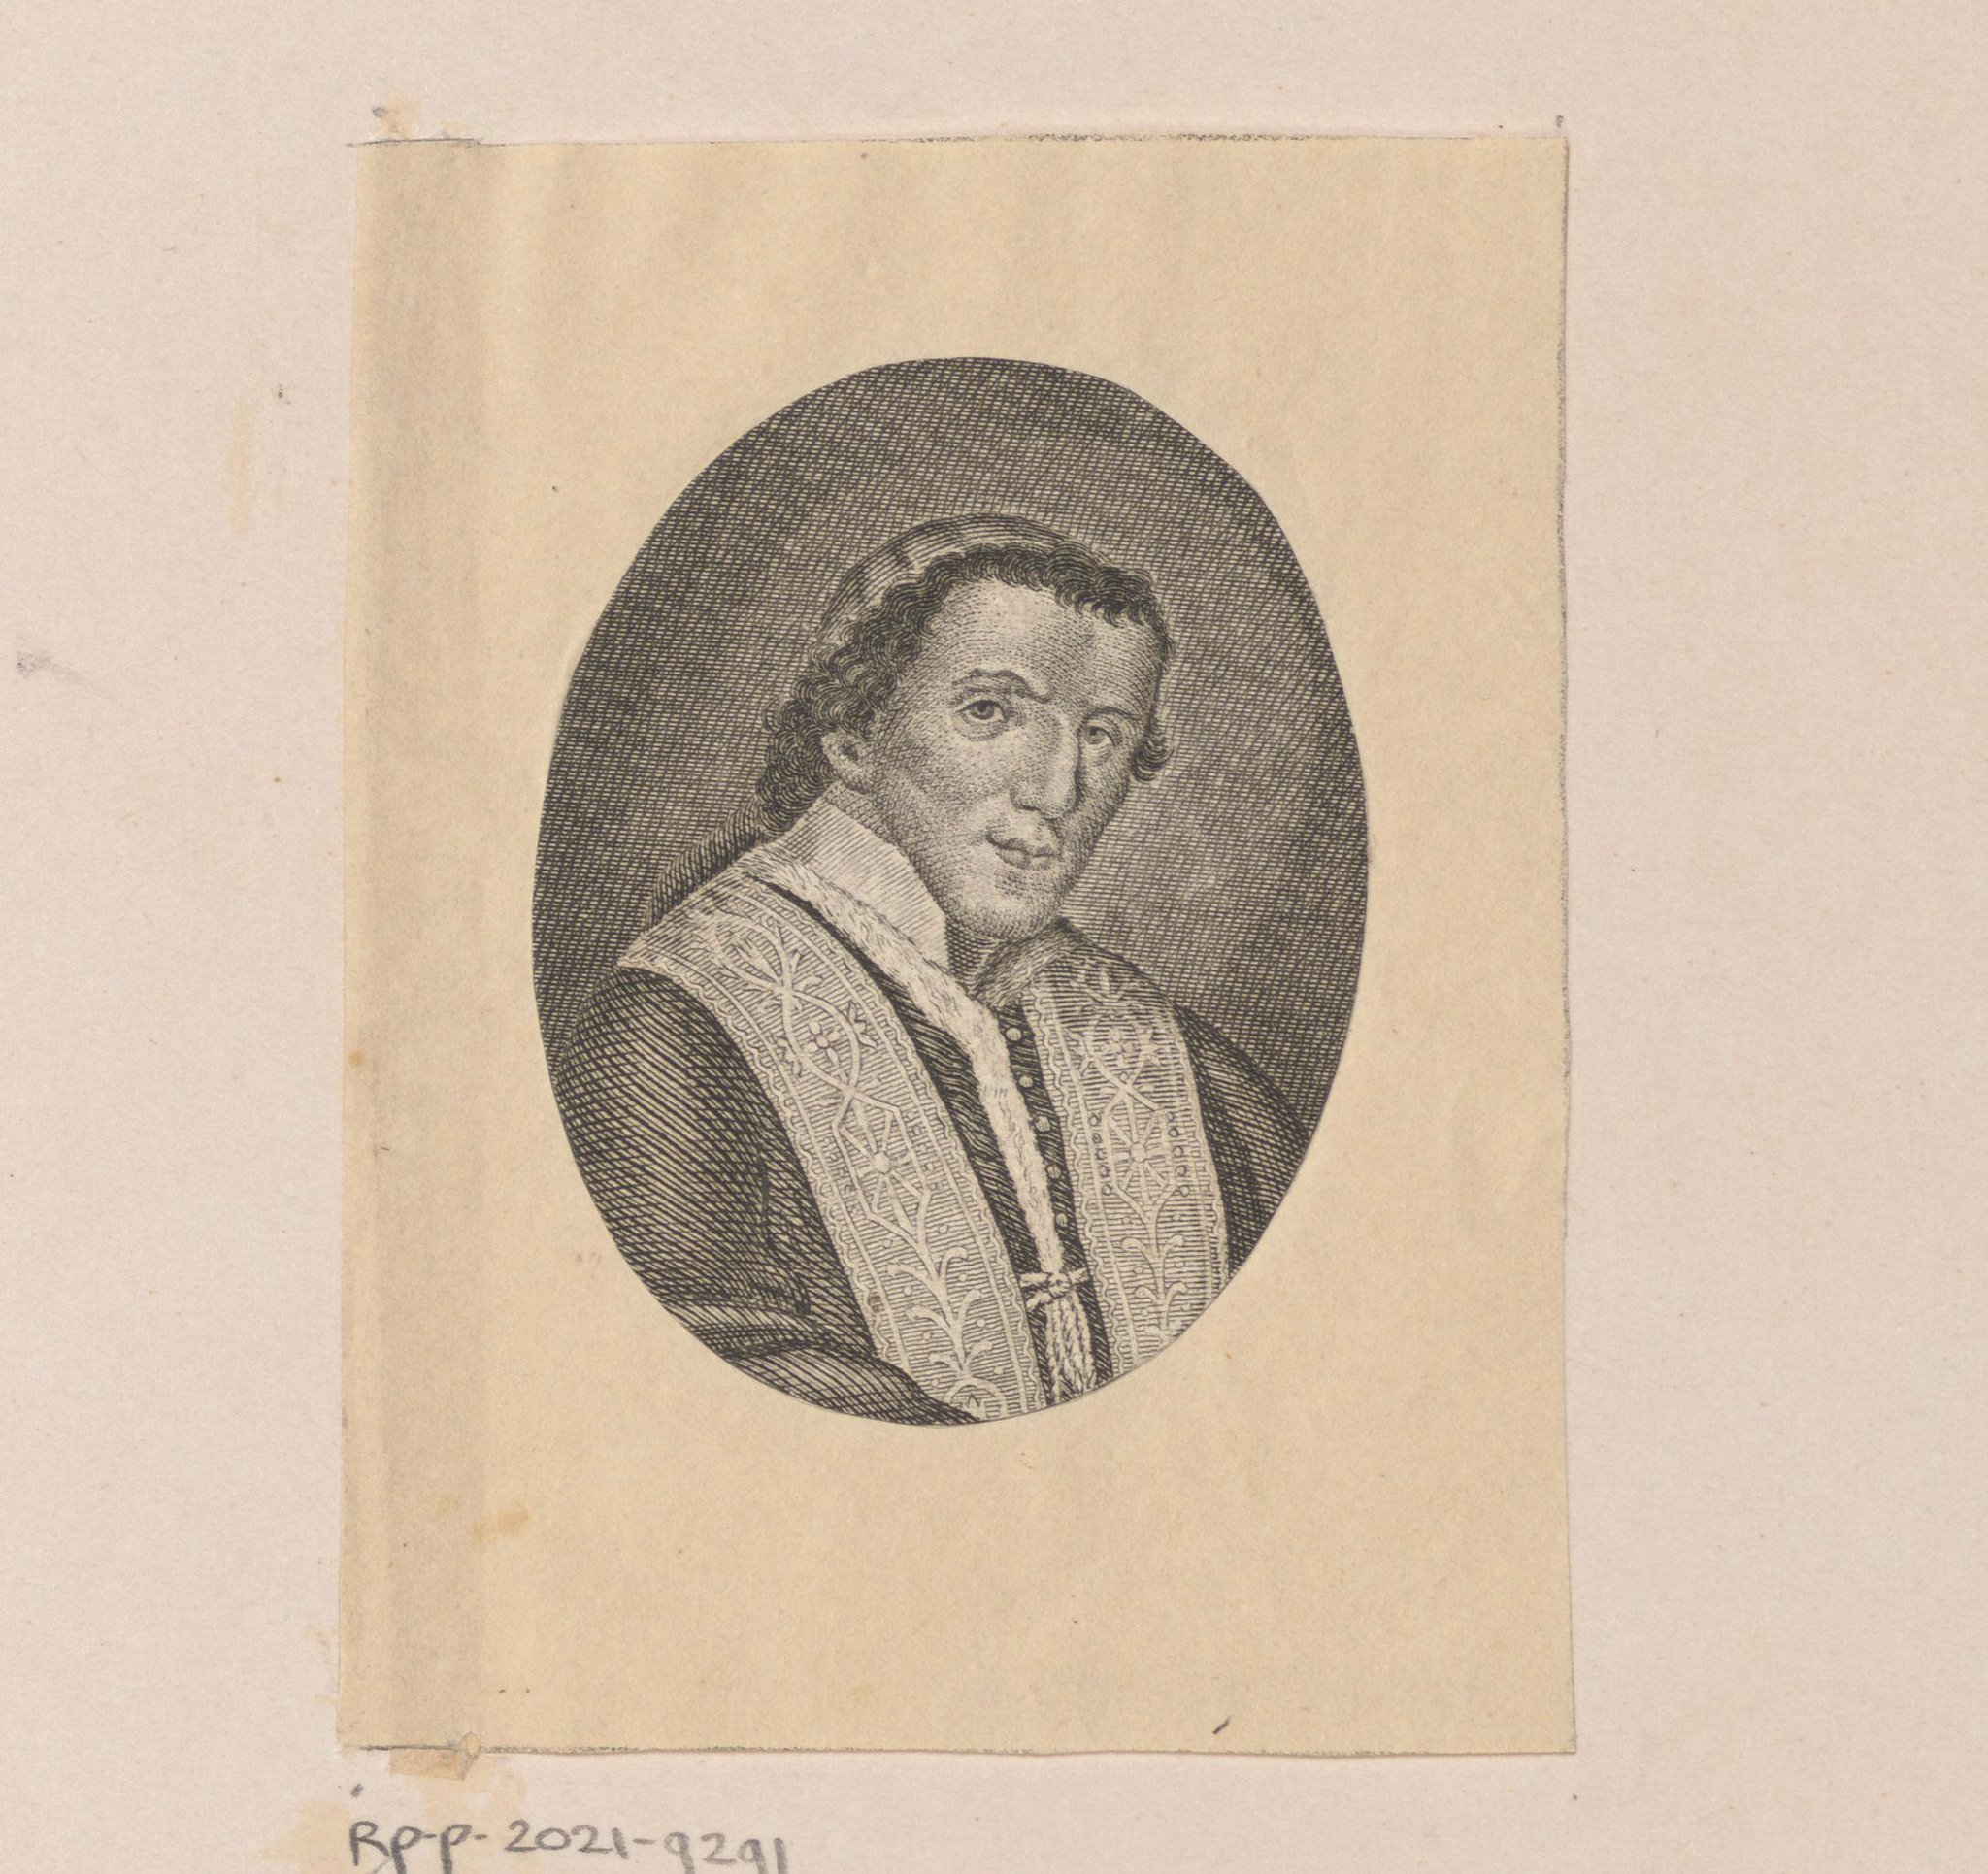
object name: print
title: Portret van paus Pius VII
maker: johann christiaan böhme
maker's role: print maker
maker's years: 1771-1835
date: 1800-1835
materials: paper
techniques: engraving, etching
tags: rome, pius vii, historical persons, pope